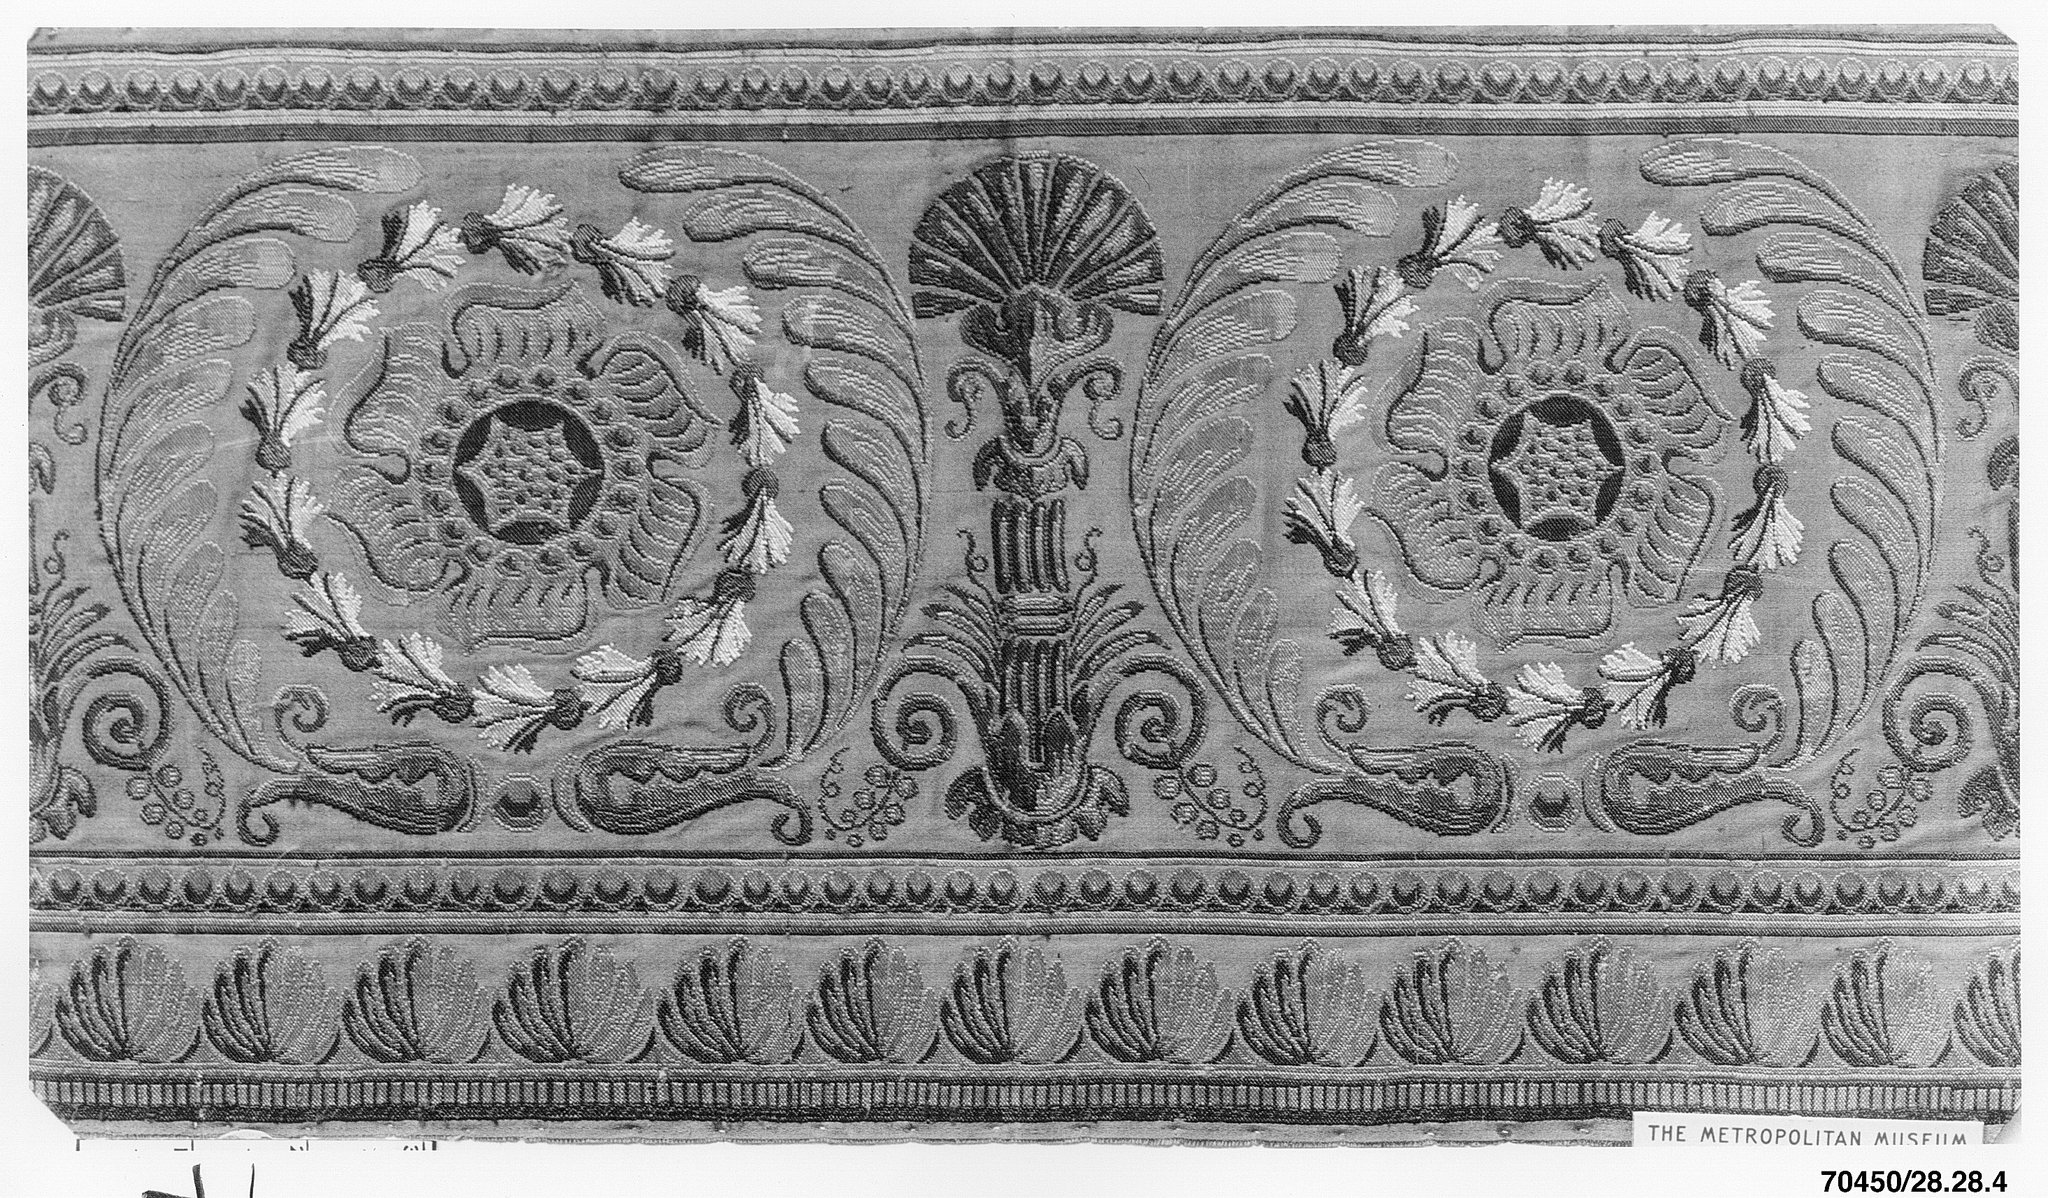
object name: border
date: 1804-1814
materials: silk